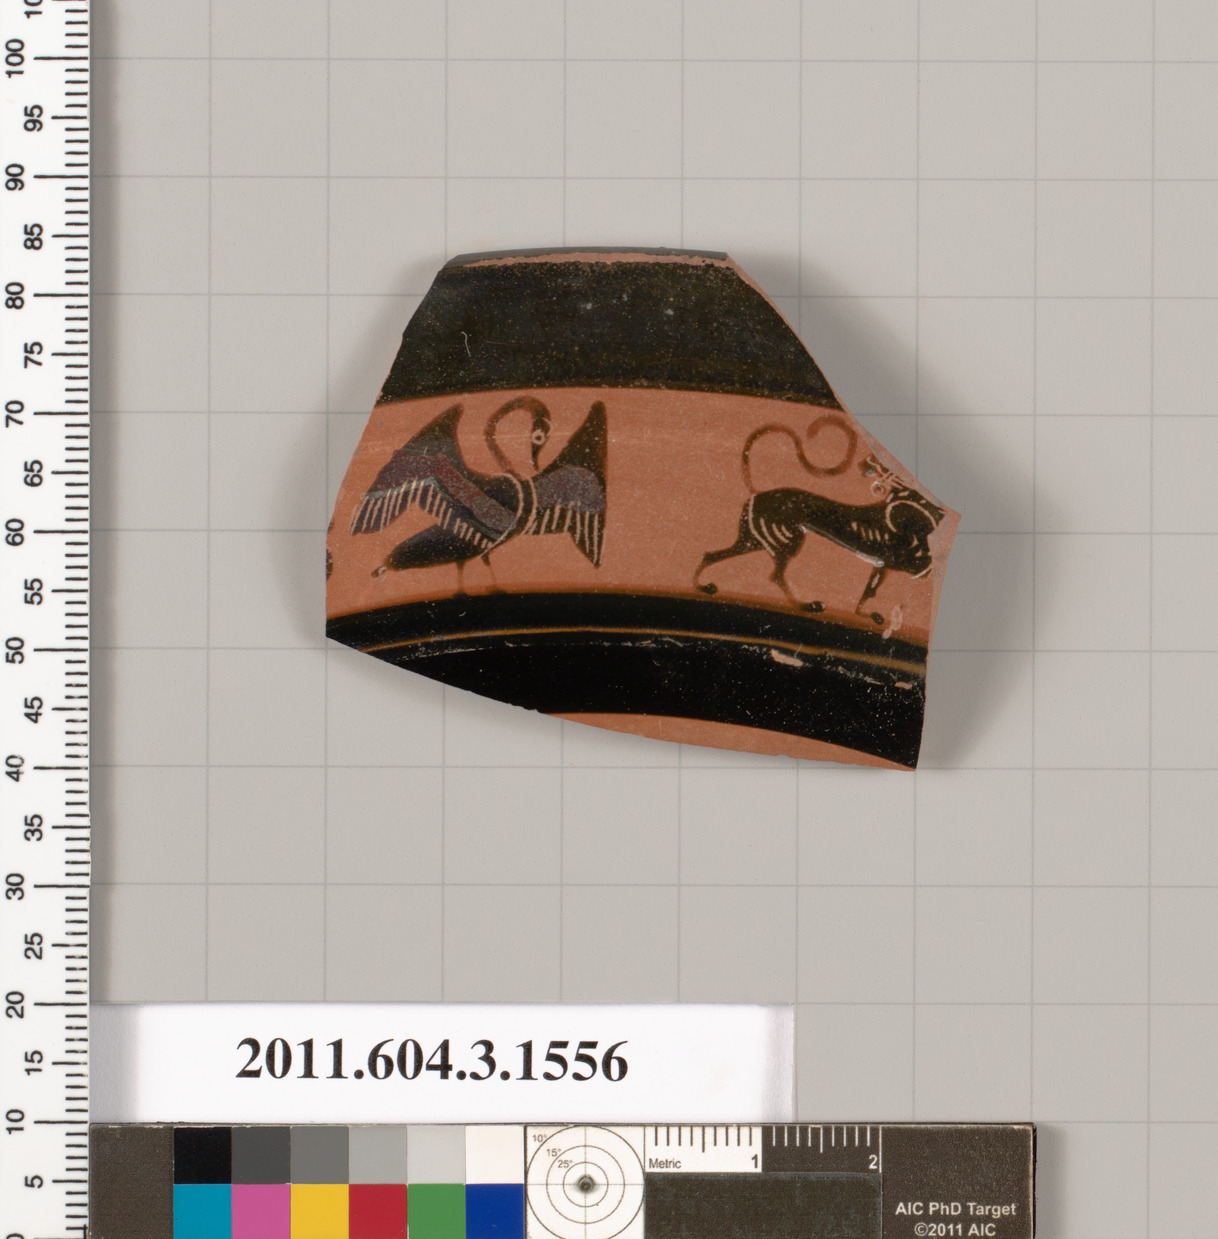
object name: kylix fragment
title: Terracotta rim fragment of a kylix: Band cup (drinking cup)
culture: greek, attic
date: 560-550 BCE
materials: terracotta